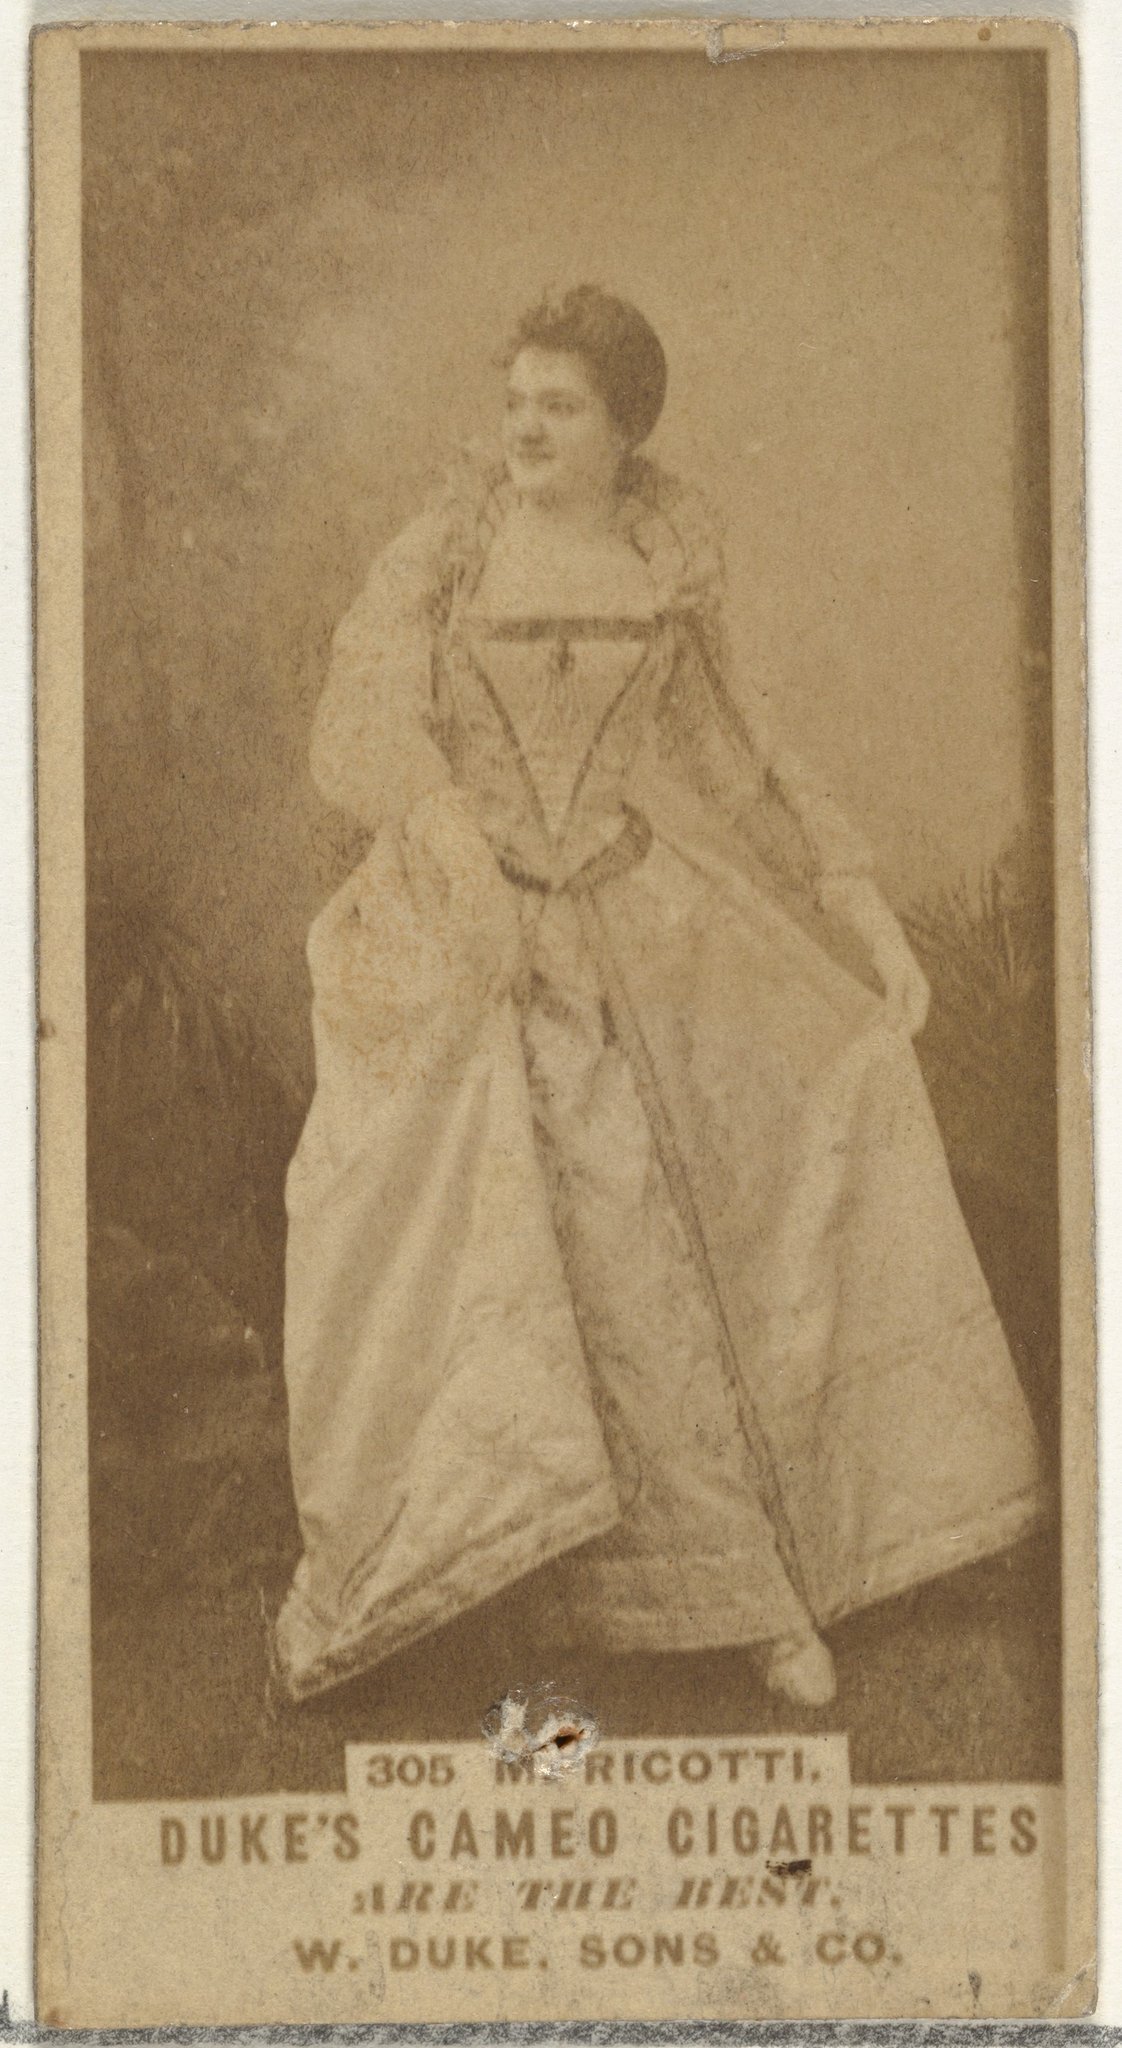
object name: photograph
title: Card Number 305, M. Ricotti, from the Actors and Actresses series (N145-5) issued by Duke Sons & Co. to promote Cameo Cigarettes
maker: w. duke, sons & co.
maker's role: publisher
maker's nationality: american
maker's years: 1870-1920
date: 1880-1889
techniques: albumen silver print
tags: portraits,women,actresses